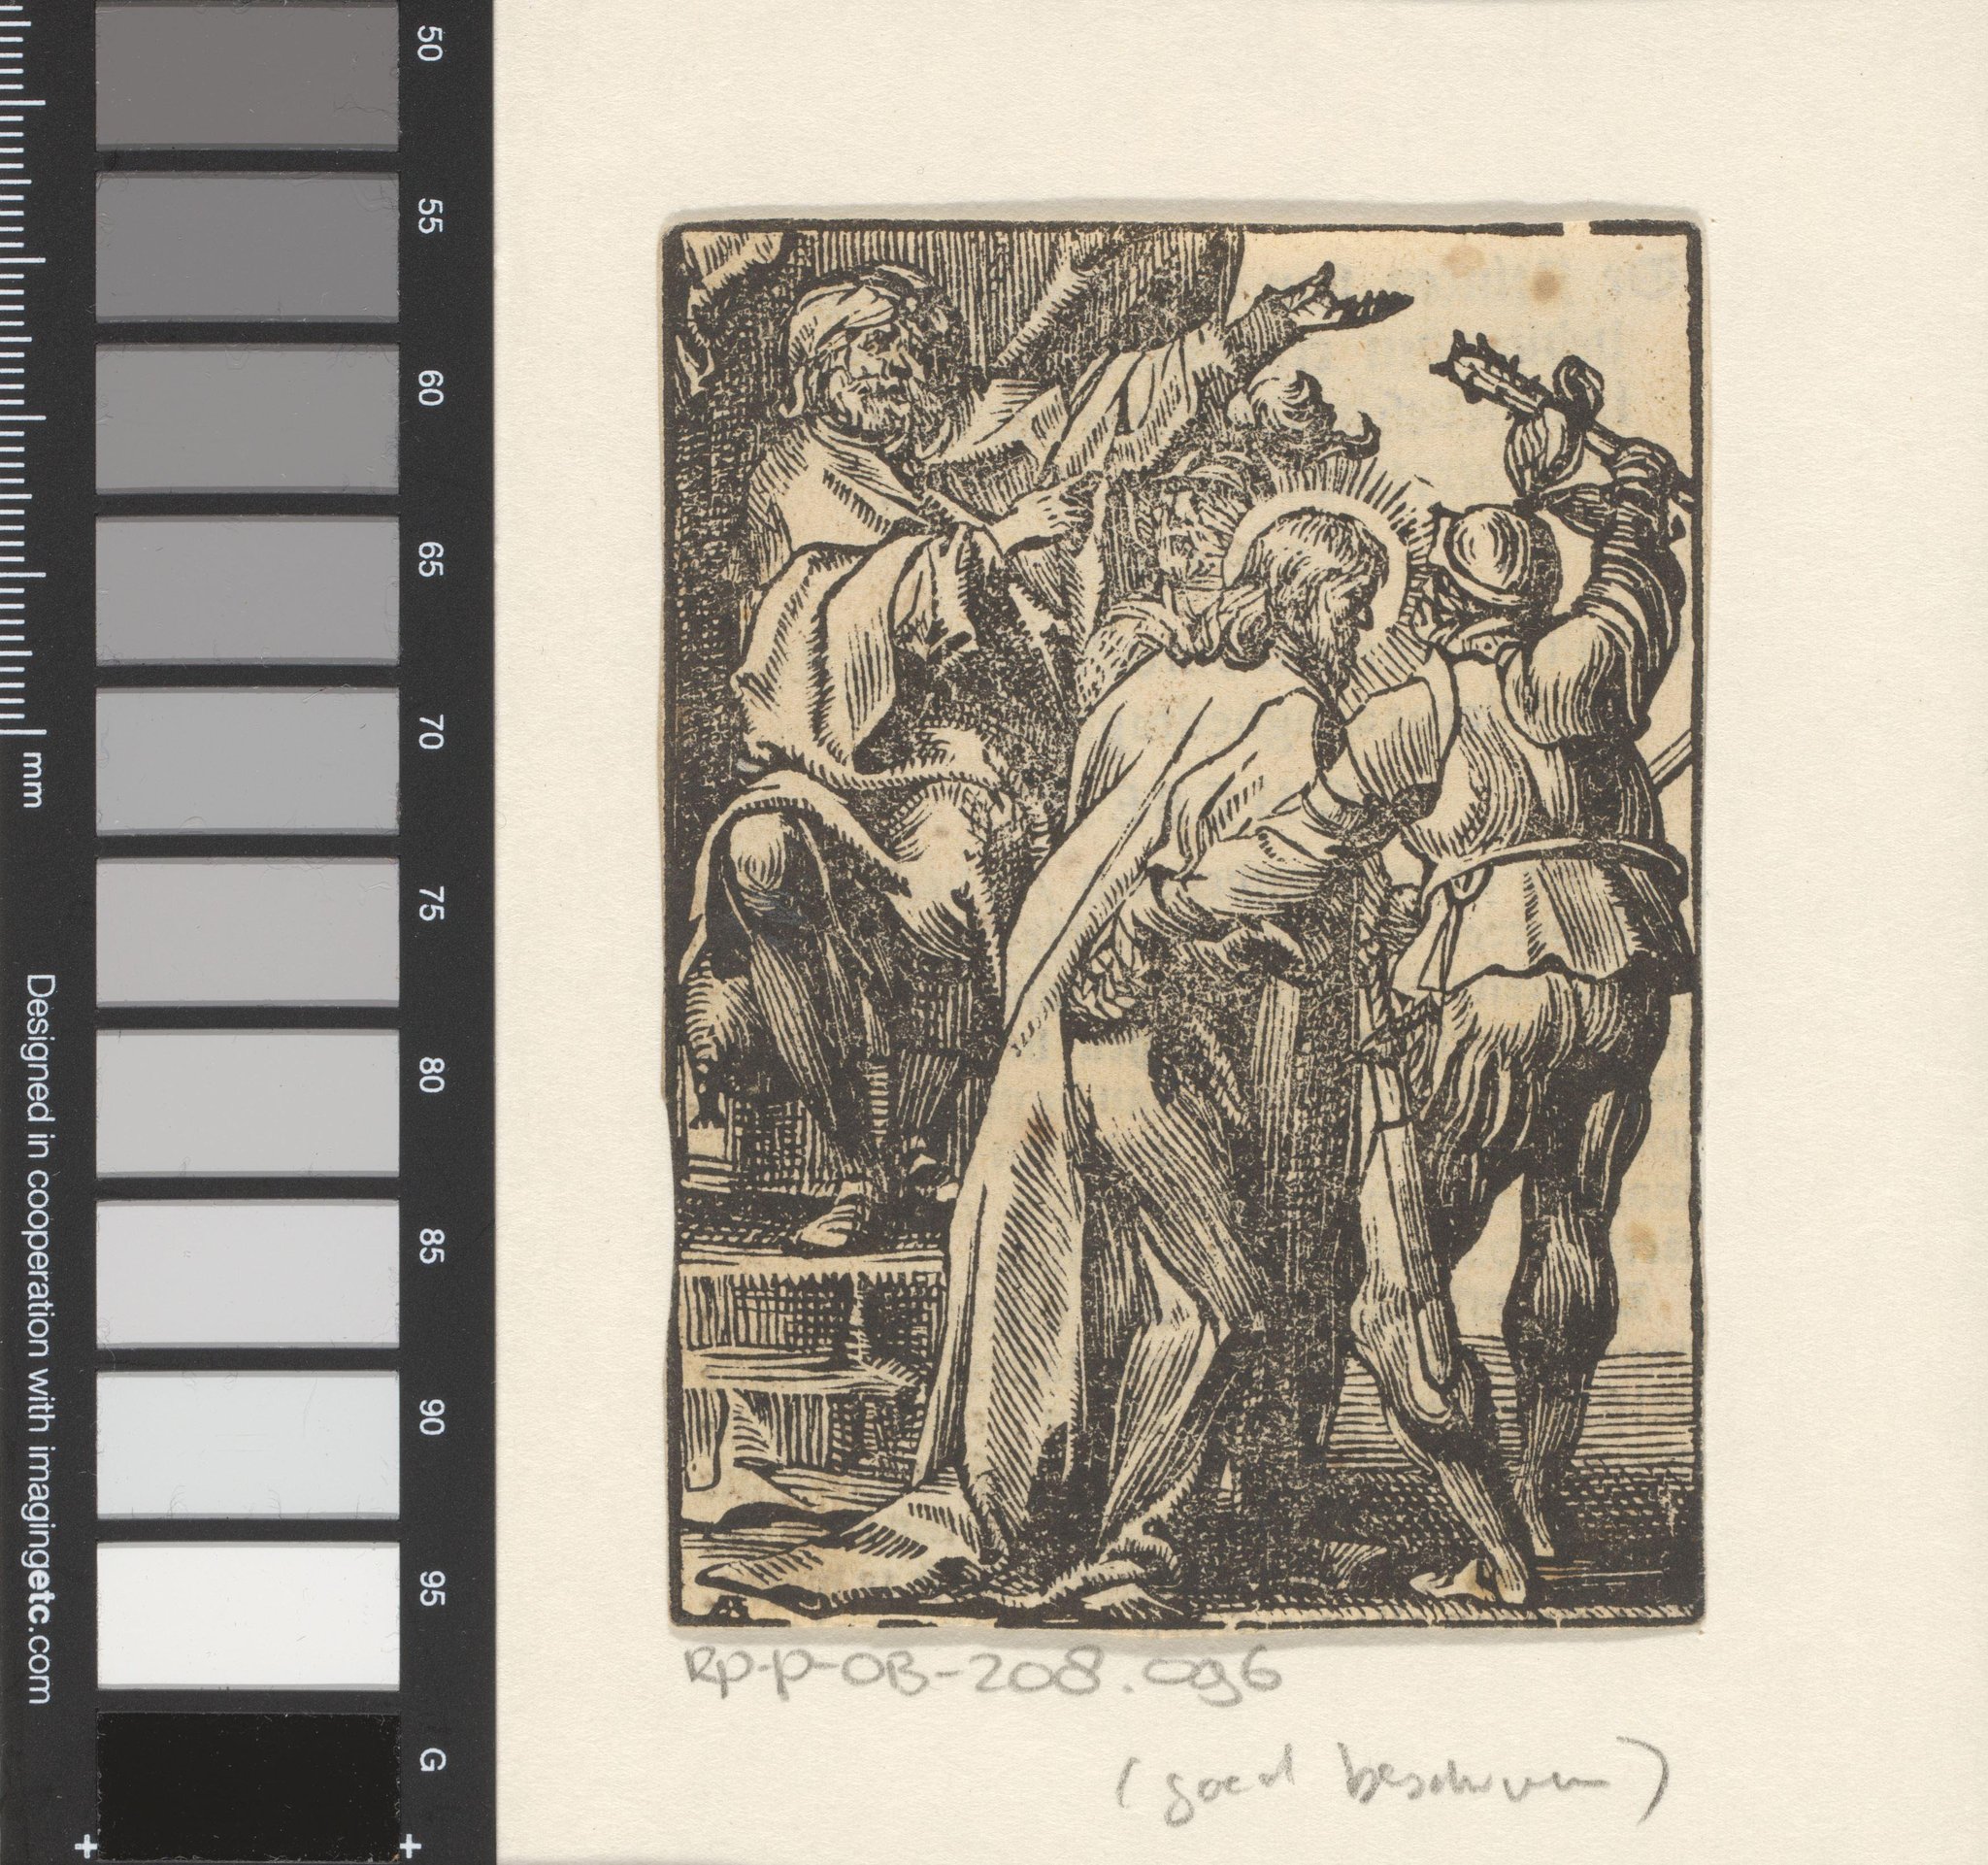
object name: book illustration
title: Christus voor Herodes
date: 1649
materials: paper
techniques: letterpress printing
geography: antwerp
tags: christ before king herod; sometimes a gorgeous robe is brought (luke 23:8-11)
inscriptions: collector's mark: Lugt 698, collector's mark: Lugt 240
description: Koning Herodes ondervraagt Christus, maar die antwoordt hem niet. Hierop bespotten Herodes en zijn soldaten Christus.